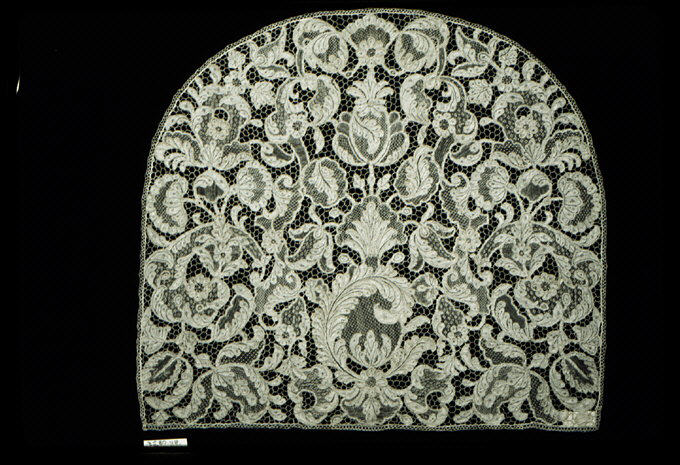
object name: cap crown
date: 1701-1800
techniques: lace